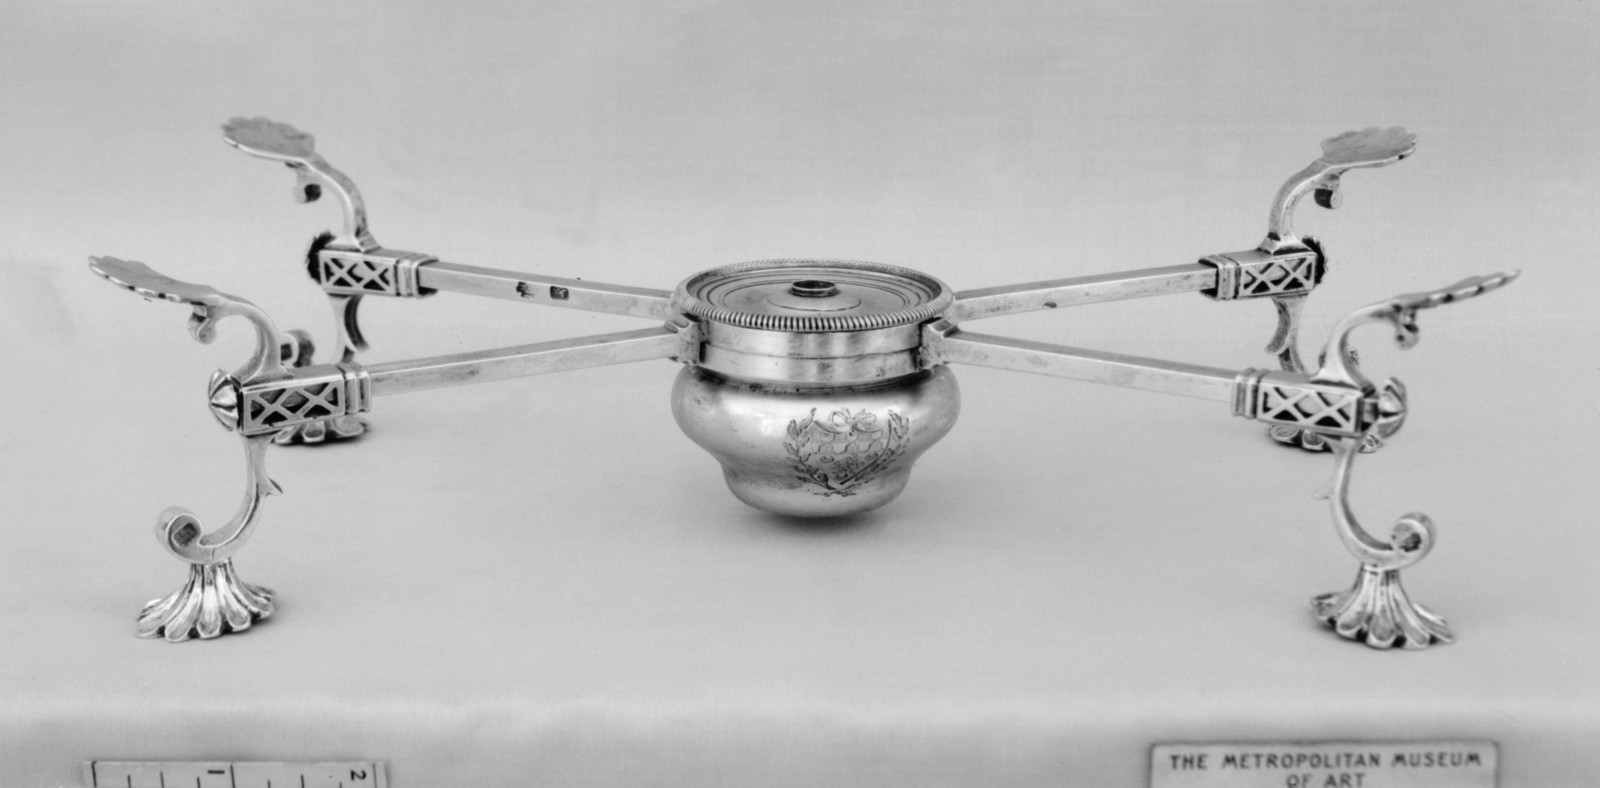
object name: dish cross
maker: samuel herbert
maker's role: maker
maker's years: 1747-1773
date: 1761-1762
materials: silver